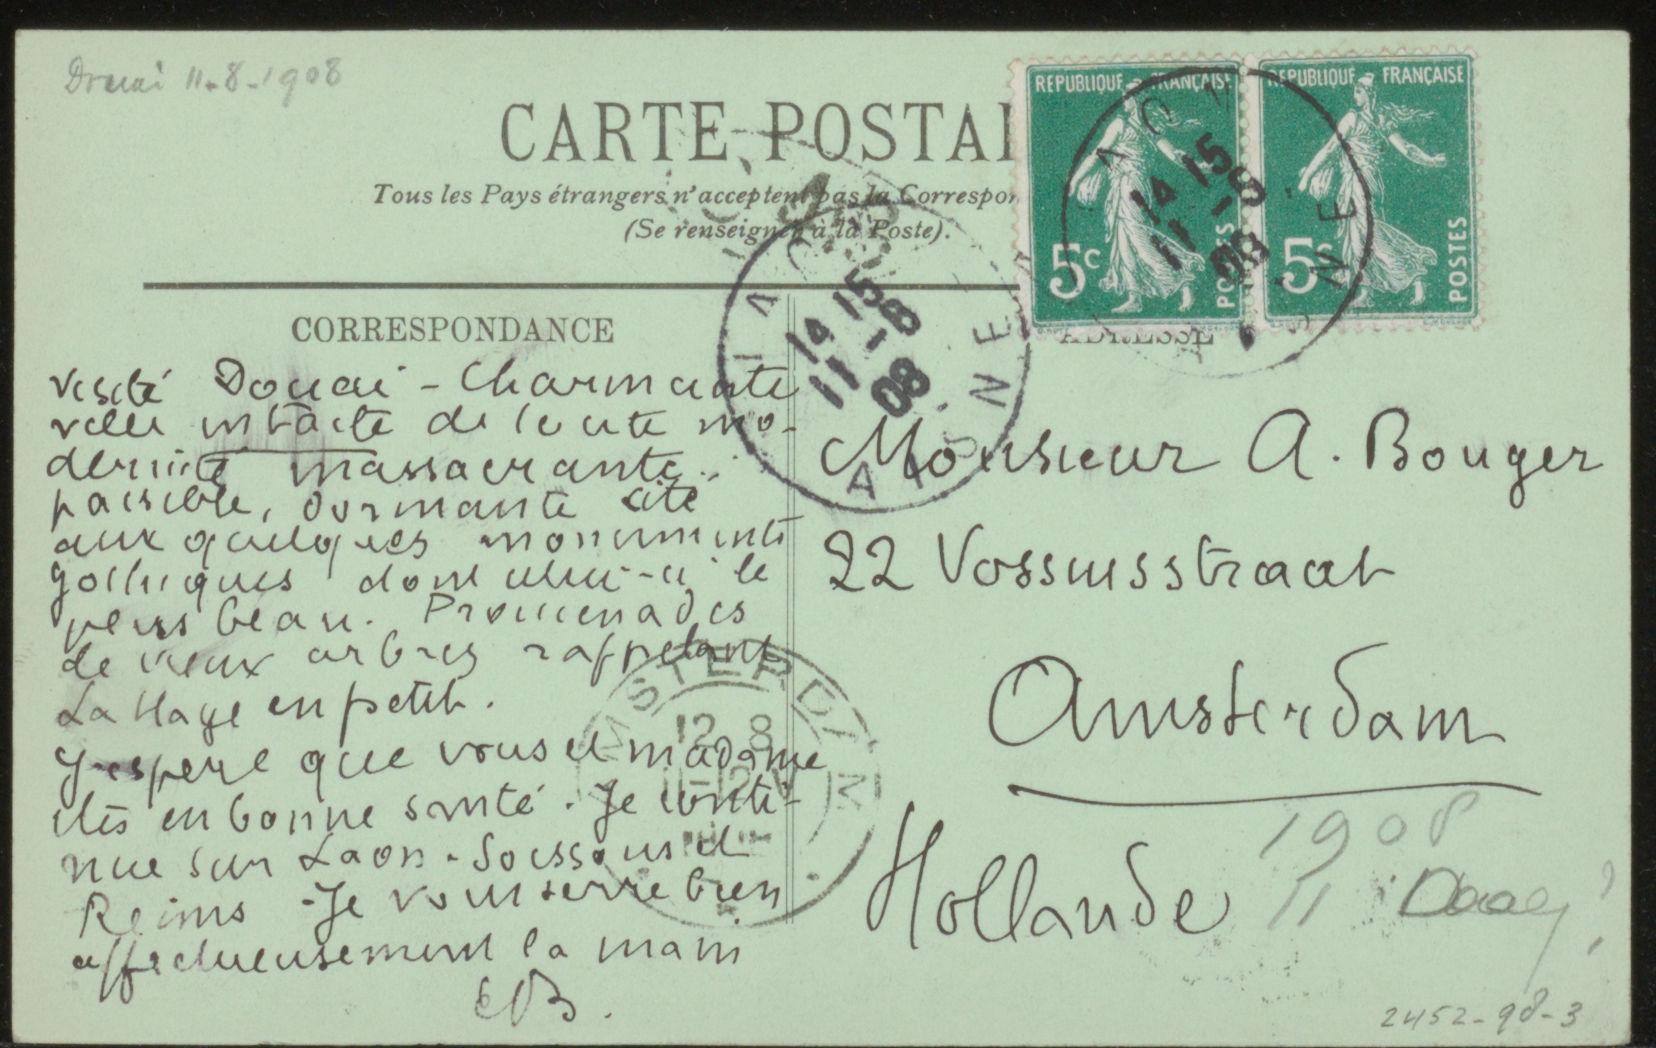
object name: ansichtkaart, prentbriefkaart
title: Prentbriefkaart aan Andries Bonger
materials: cardboard, ink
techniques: photograph, pen, writing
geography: laon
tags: amsterdam, andries bonger, travelling; tourism, the hague